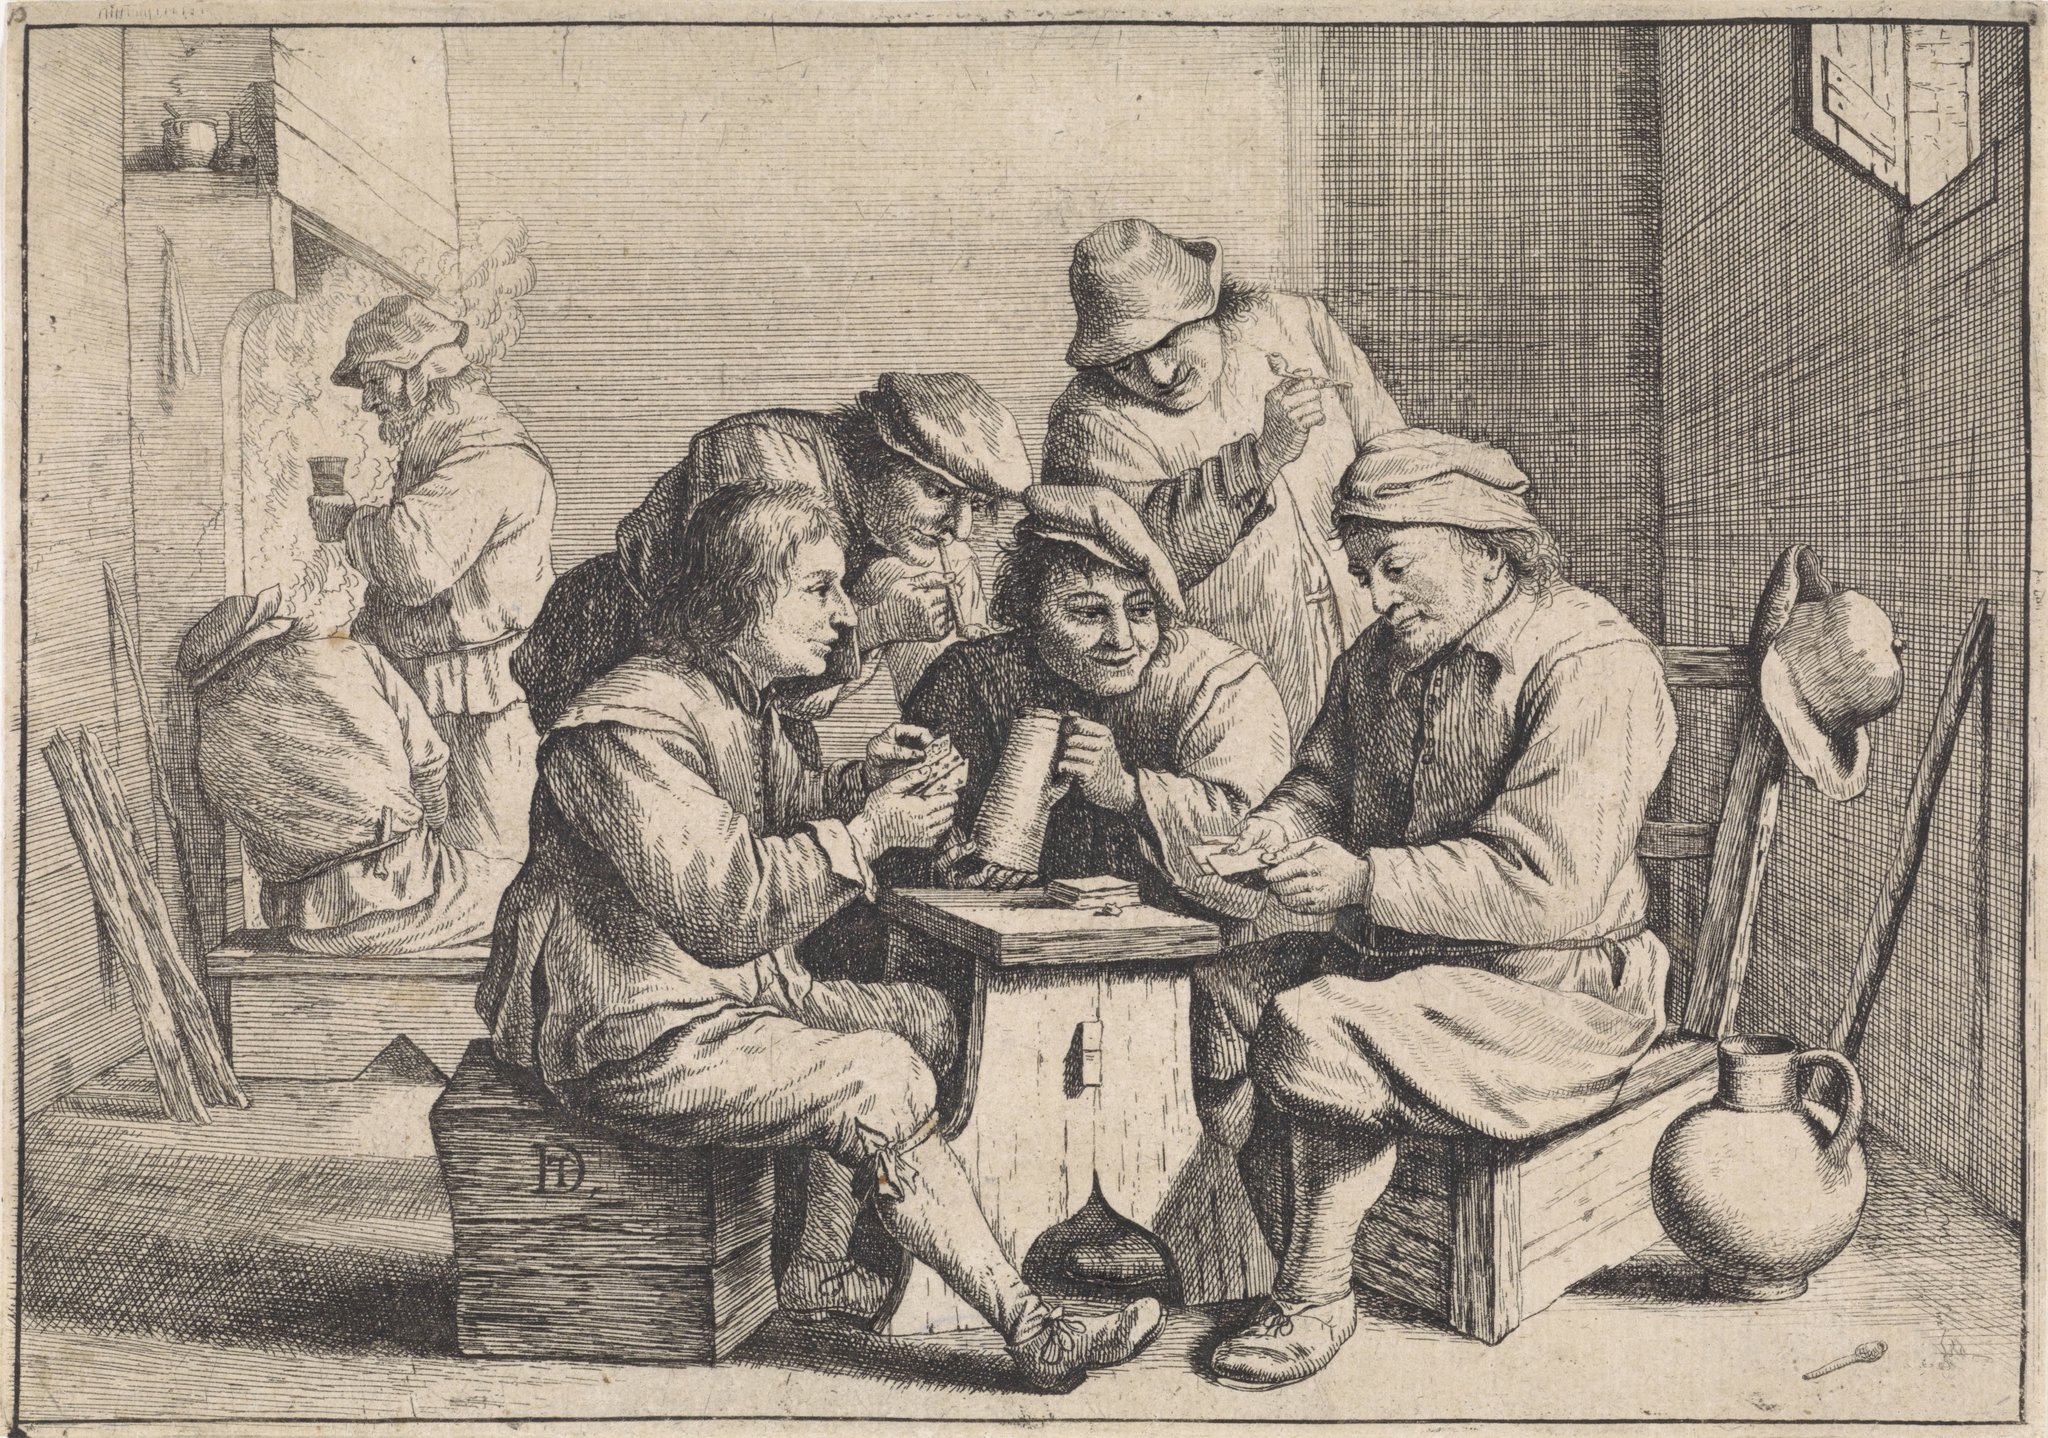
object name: print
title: Kaartspelers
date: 1626-1740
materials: paper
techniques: etching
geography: low countries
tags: pipe ~ tobacco, open hearth, fire-place, playing-cards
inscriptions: collector's mark: Lugt 2228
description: In een interieur staan en zitten vijf boeren rond een tafel. Twee van hen spelen kaart. Links twee mannen bij de haard.